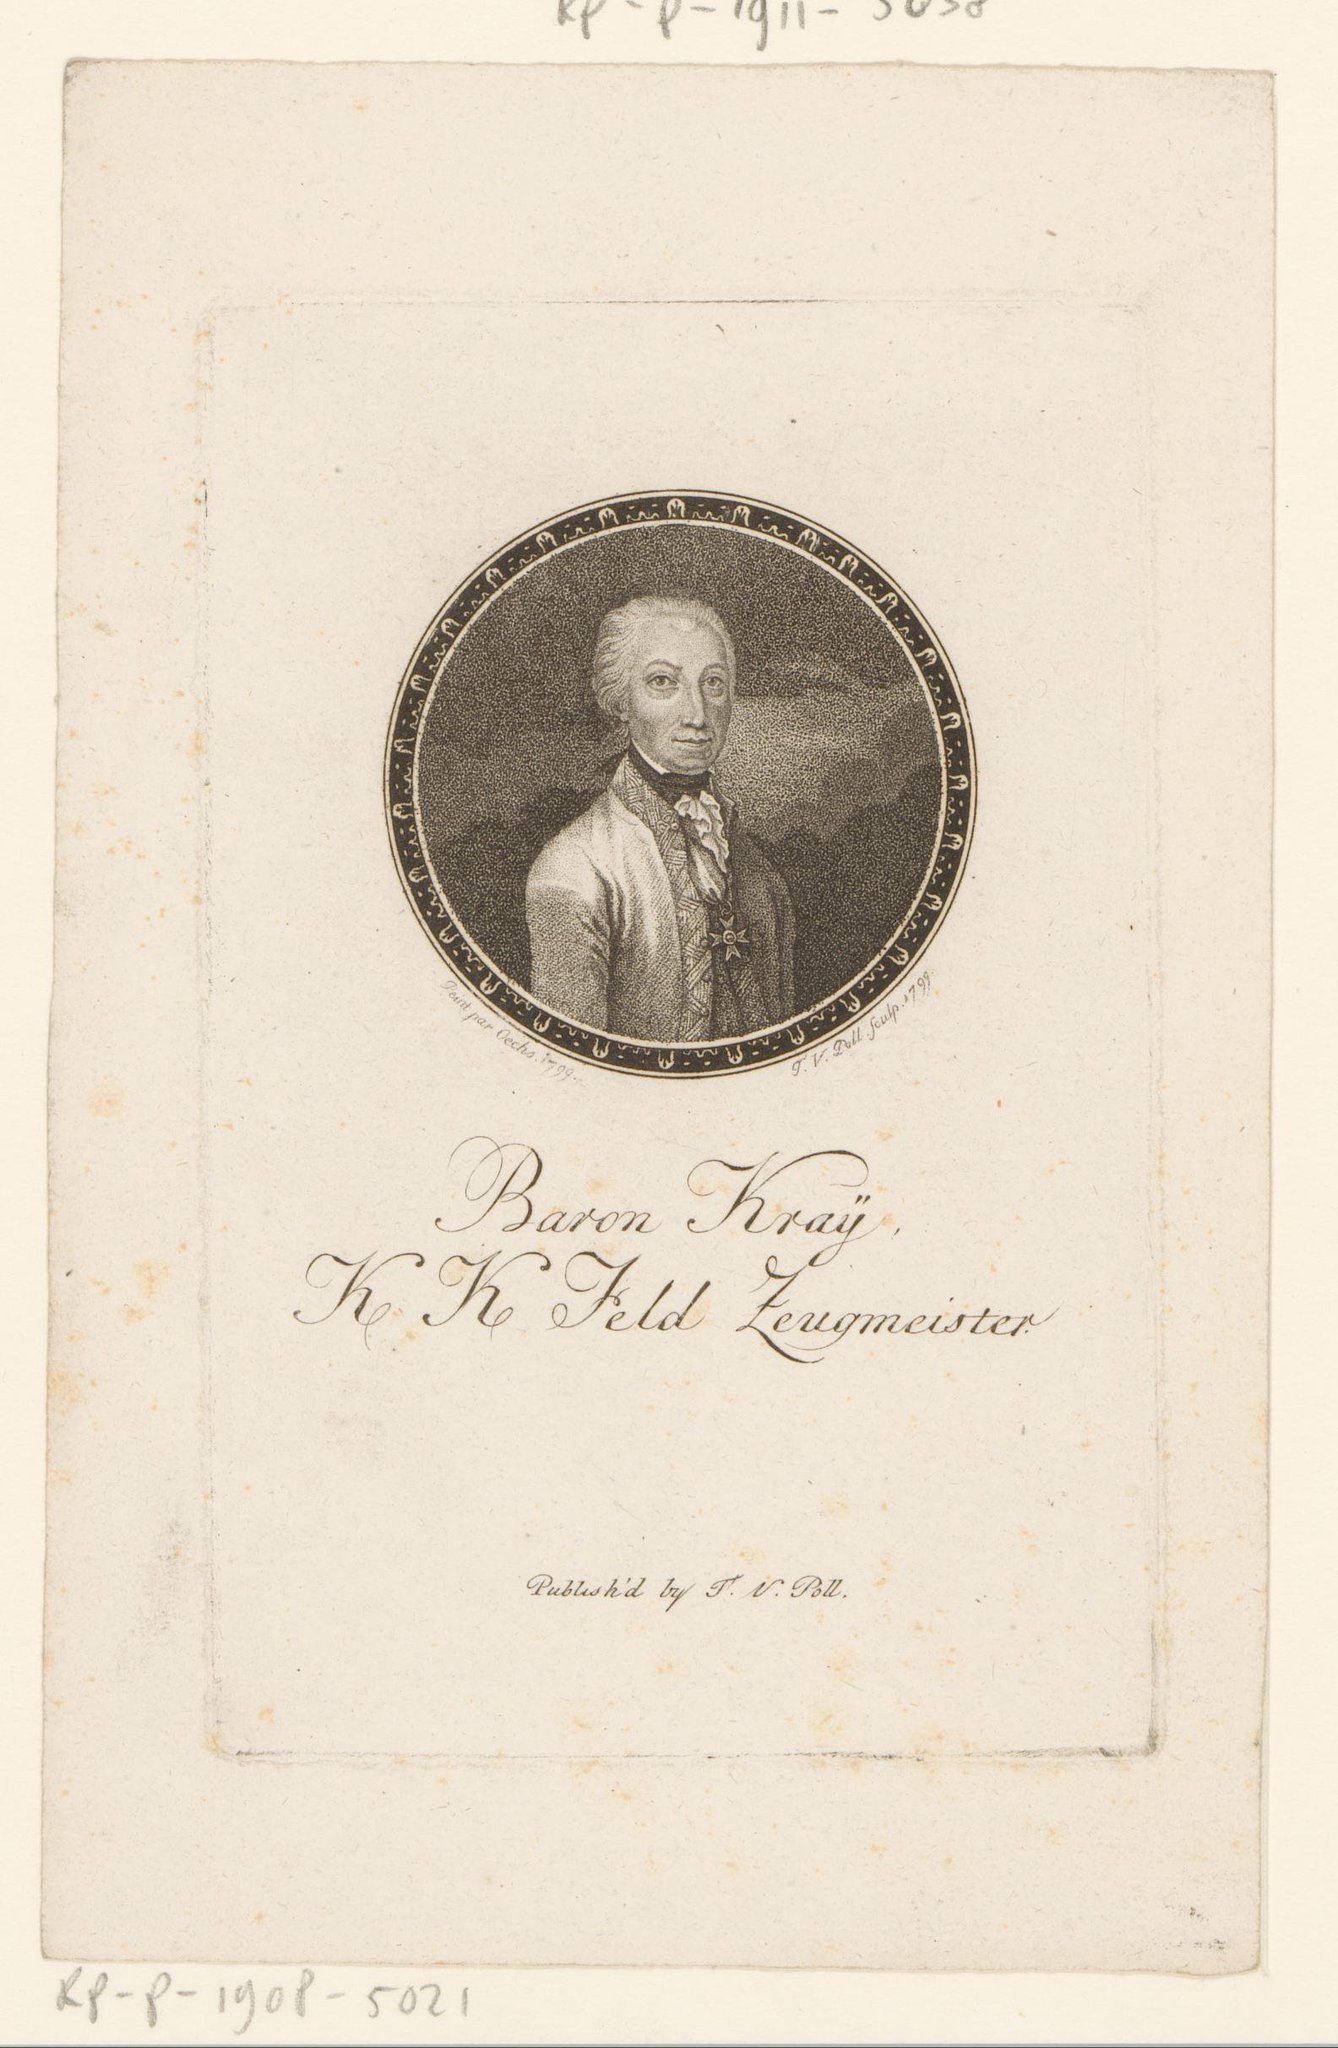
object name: print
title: Portret van Paul Kray von Krajowa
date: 1780-1880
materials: paper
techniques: engraving, etching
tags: historical persons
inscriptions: collector's mark: Lugt 2228